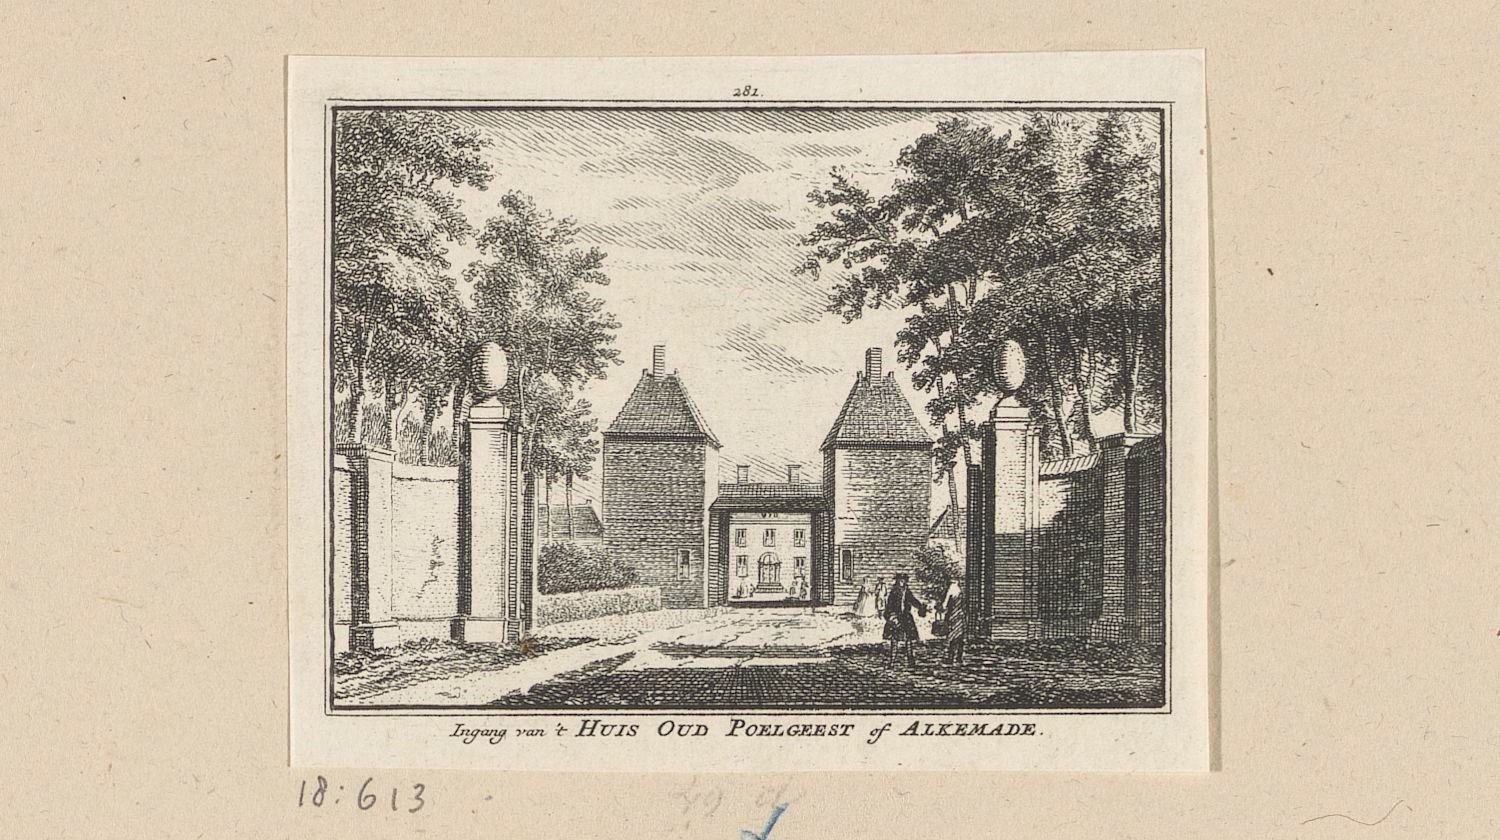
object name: print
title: 't Huis Oud Teilingen of Lokhorst, by Warmond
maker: hendrik spilman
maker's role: draughtsman, painter, print maker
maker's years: 1721-1784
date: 1750-1792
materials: paper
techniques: engraving, etching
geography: haarlem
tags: castle, bridge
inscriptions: collector's mark: Lugt 2228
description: Prent ook gebruikt in: Het verheerlykt Nederland of kabinet van hedendaagsche gezigten van steden, dorpen (…). 9 delen. Amsterdam: Isaak Tirion en weduwe Isaak Tirion, 1745-1774, dl. 3 (1750), ill. 297. Of in: Nederlandsche tafereelen; of eene keurige verzameling van negen honderd fraaije gezigten van steden, dorpen, sloten, oudheden (….). 9 delen. Amsterdam: Jan de Groot, 1792, dl. 3, ill. 297.